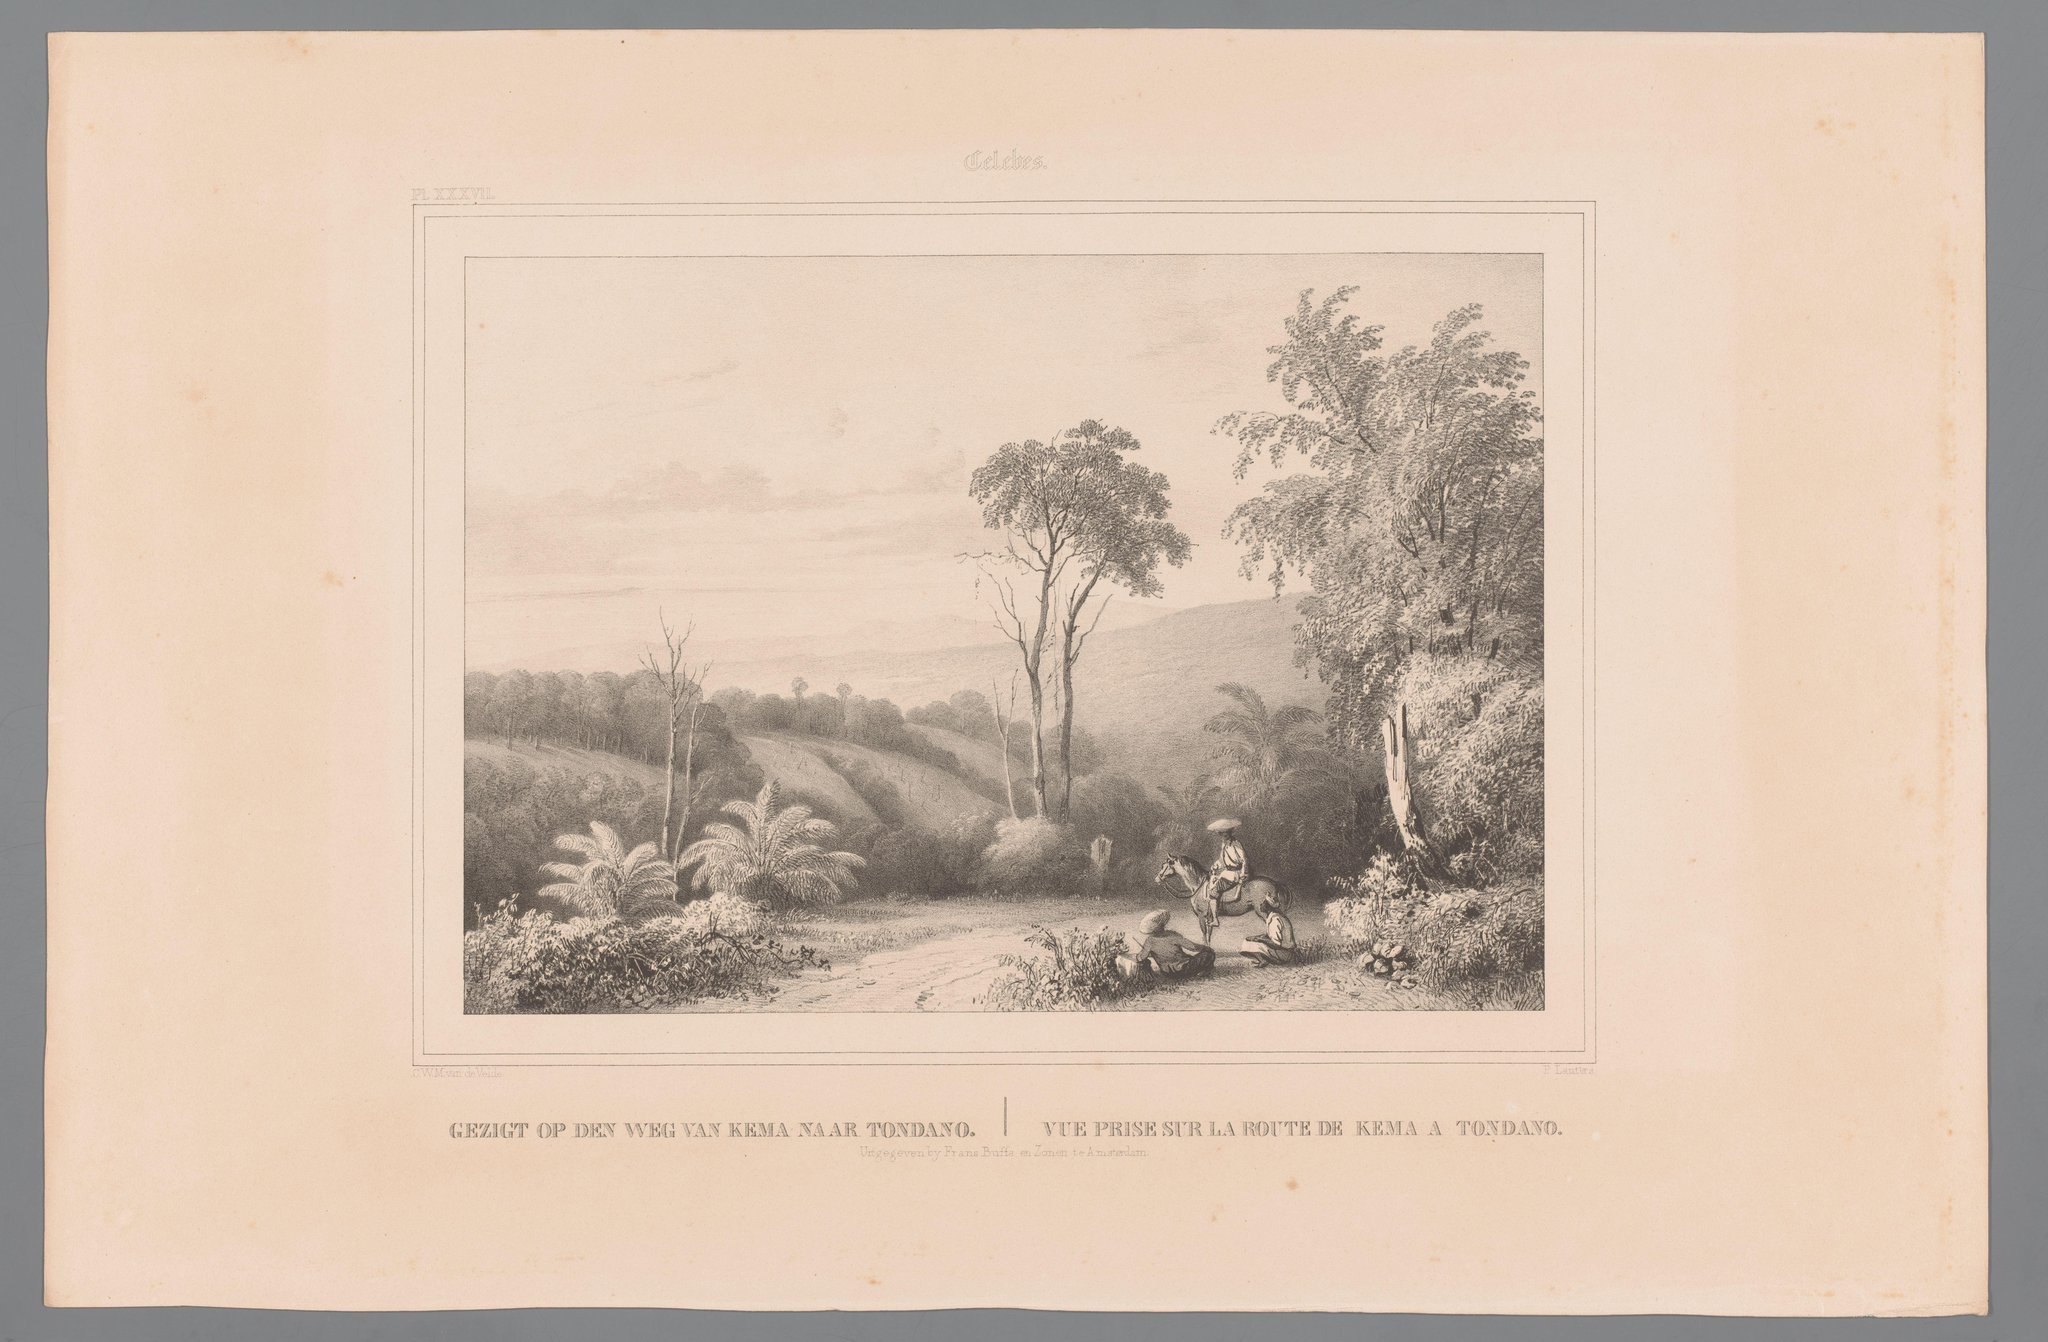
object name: print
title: Gezigt op den weg van Kema naar Tondano / Vue prise sur la route de Kema a Tondano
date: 1847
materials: paper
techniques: lithograph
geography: amsterdam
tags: low hill country, road, path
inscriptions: collector's mark: Lugt 2228